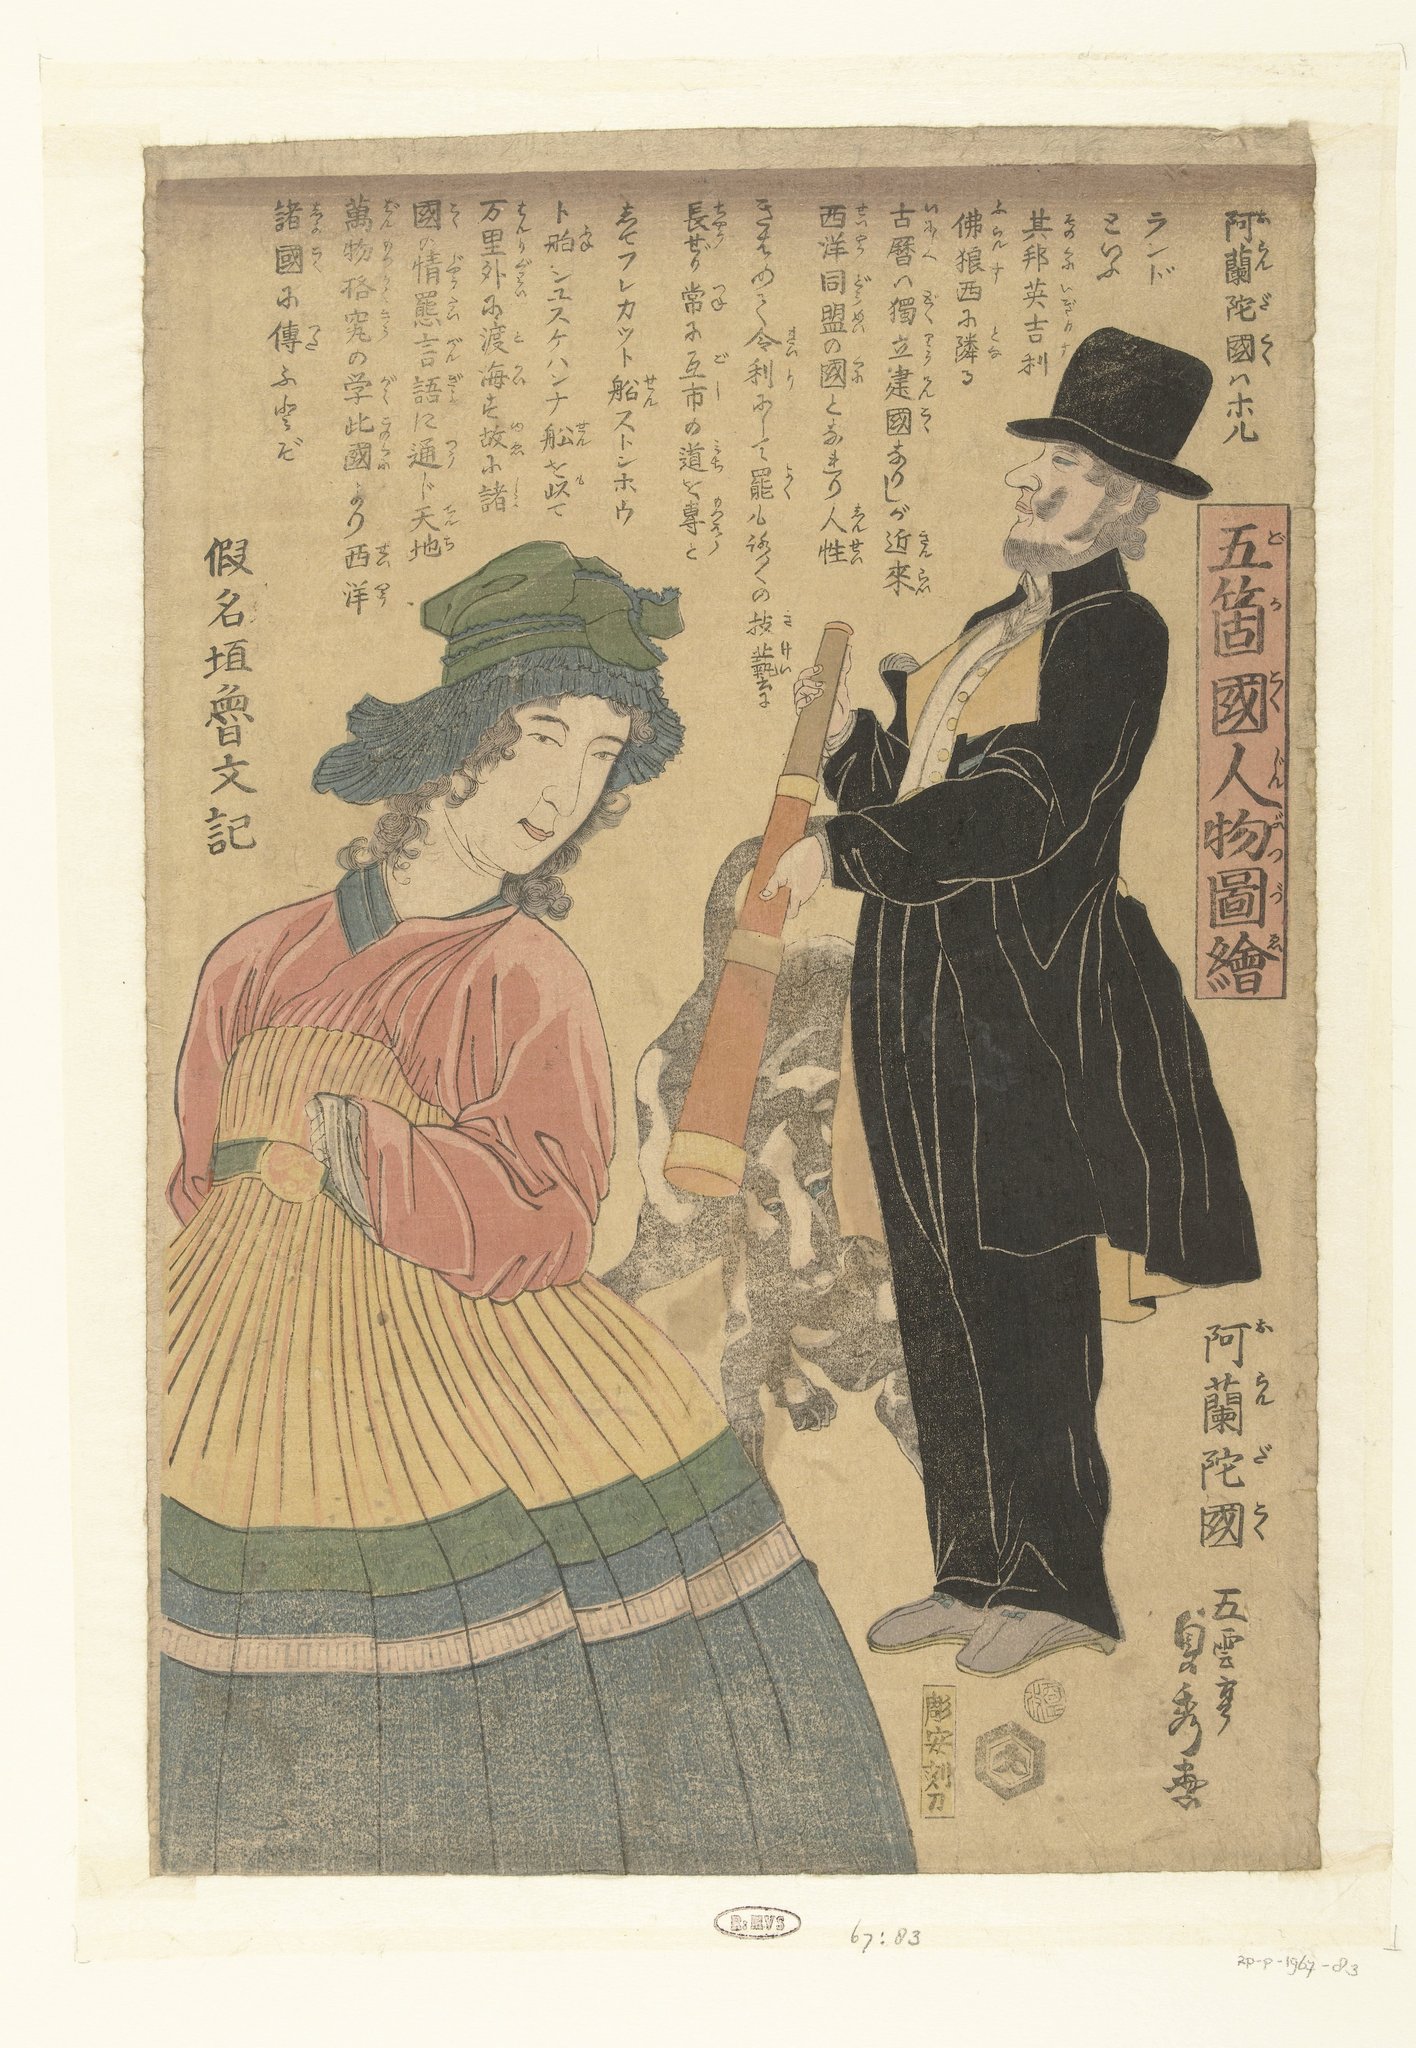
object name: print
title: Orandakoku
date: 1861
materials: paper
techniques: woodcut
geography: japan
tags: adult woman, adult man, optical instruments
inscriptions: collector's mark: Lugt 2228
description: Vrouw in kleurige kleding en man in zwart kostuum met telescoop in handen; op de achtergrond een grote hond. De tekst vermeldt eigenschappen van Nederlanders. (Yokohama-e)